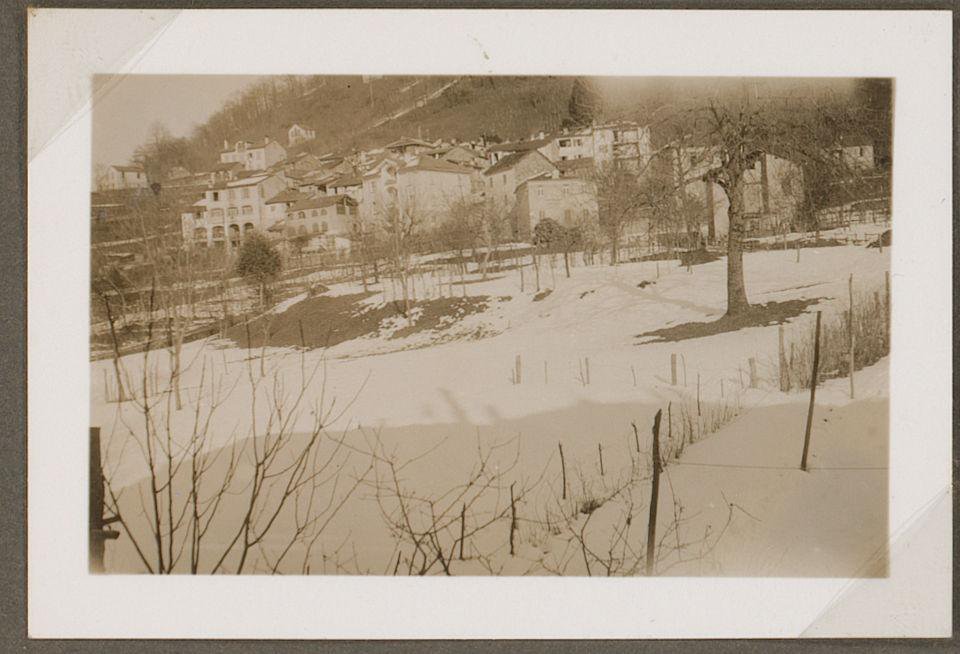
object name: album leaf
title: Gezicht op Campestro vanuit Villa Hari in Tesserete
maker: Anonymous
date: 1934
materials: paper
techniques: gelatin silver print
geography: tesserete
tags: prospect of village, silhouette of village, snow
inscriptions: number: ‘49’